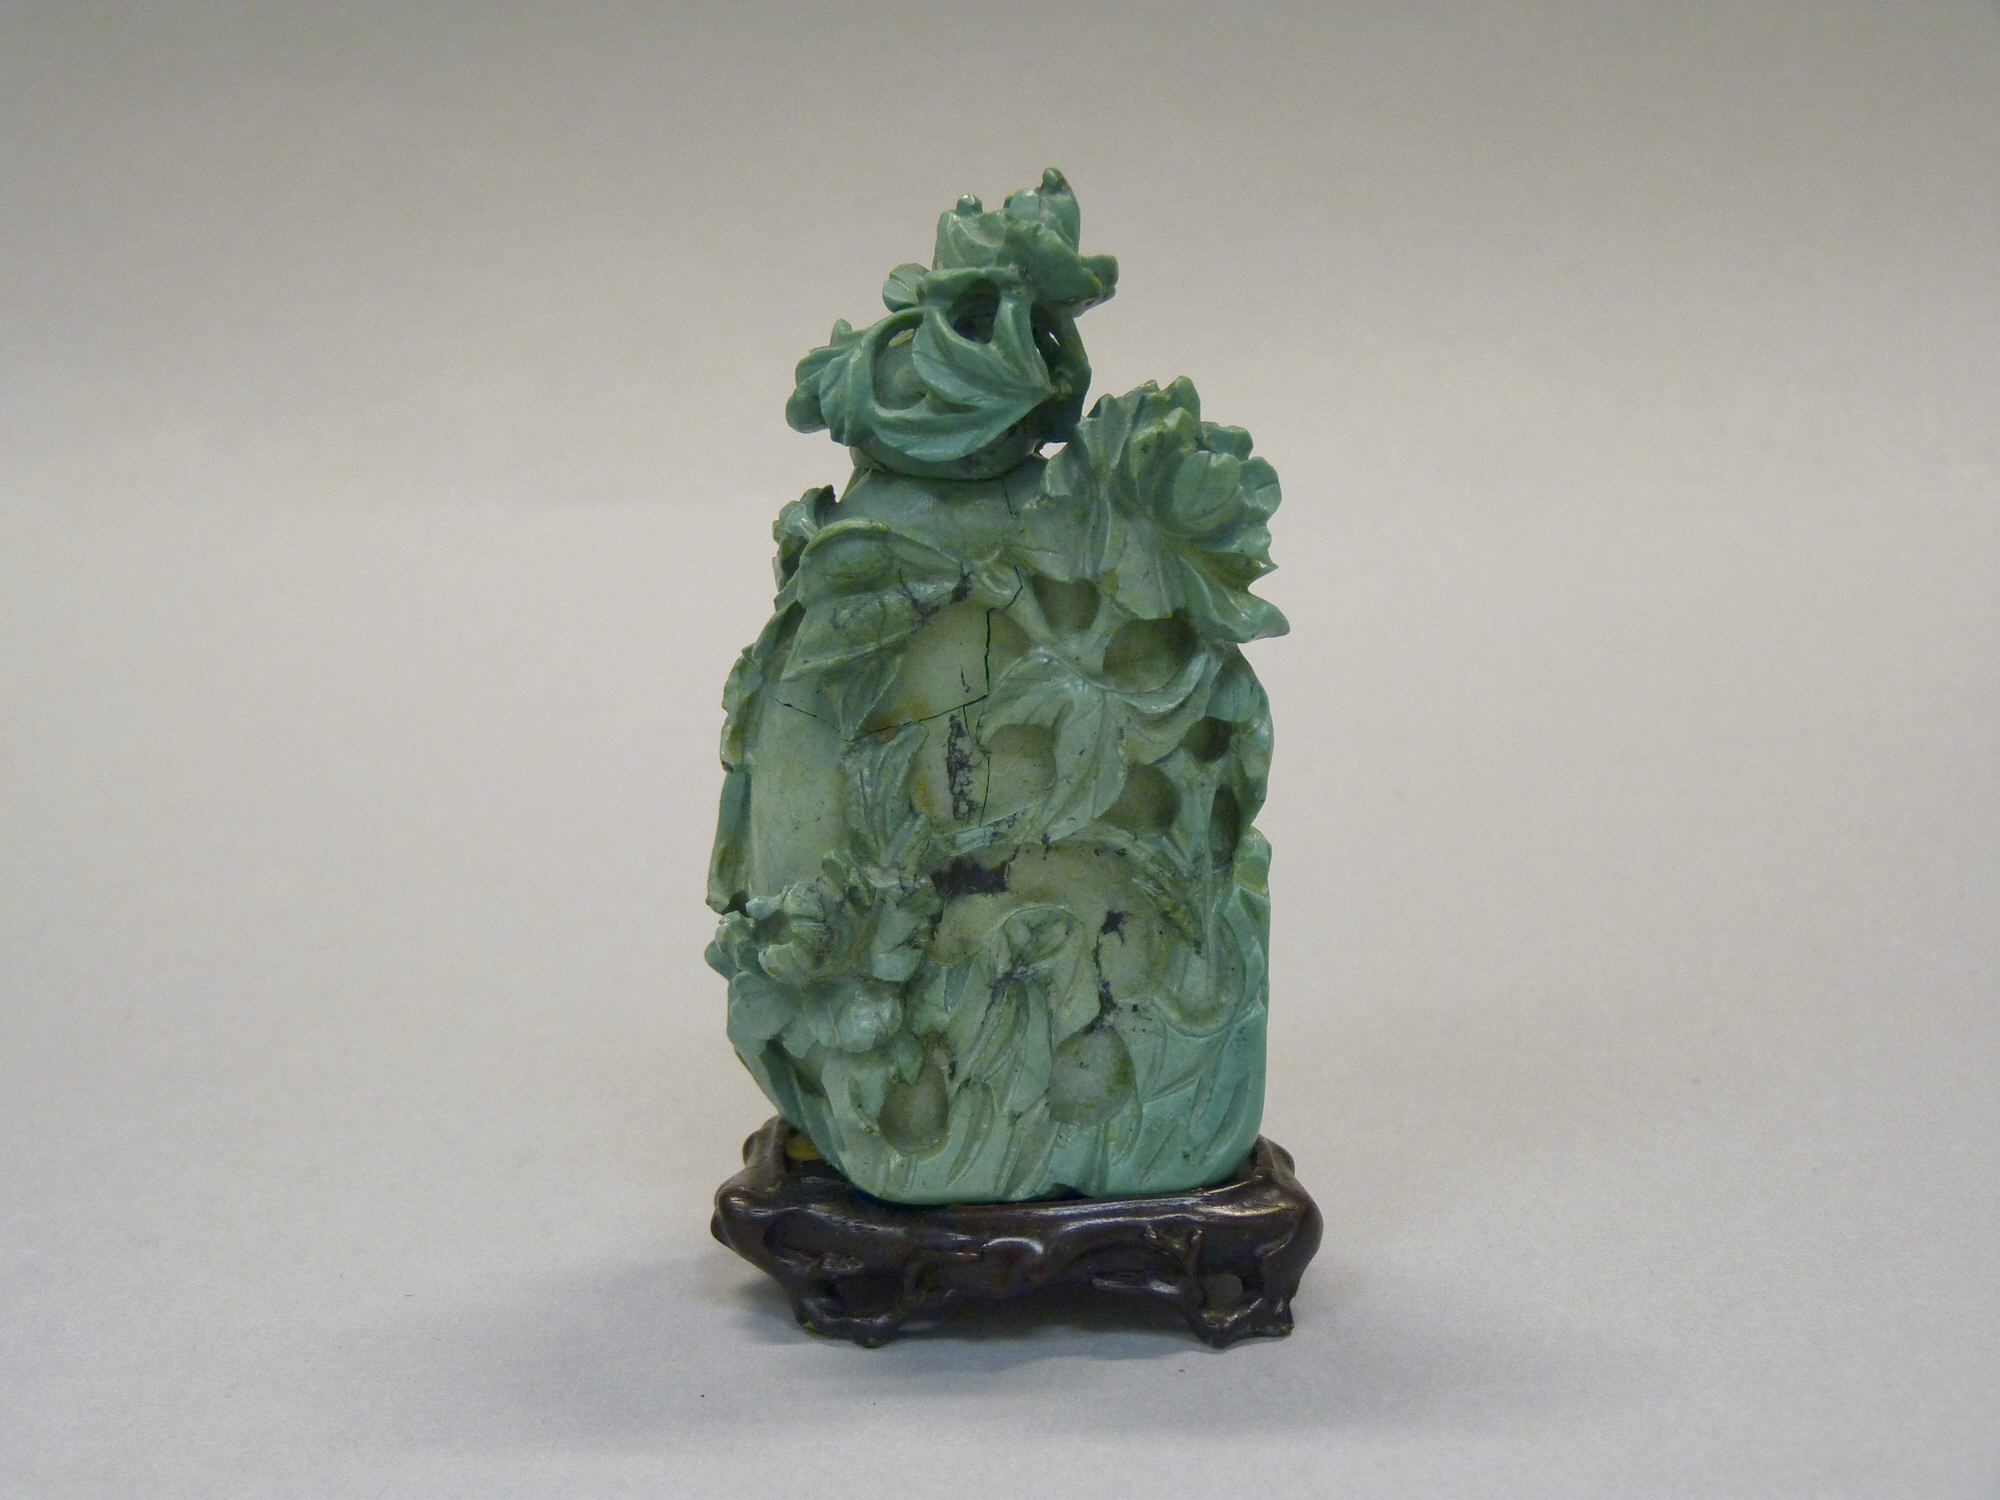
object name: snuff bottle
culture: chinese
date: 1801-1900